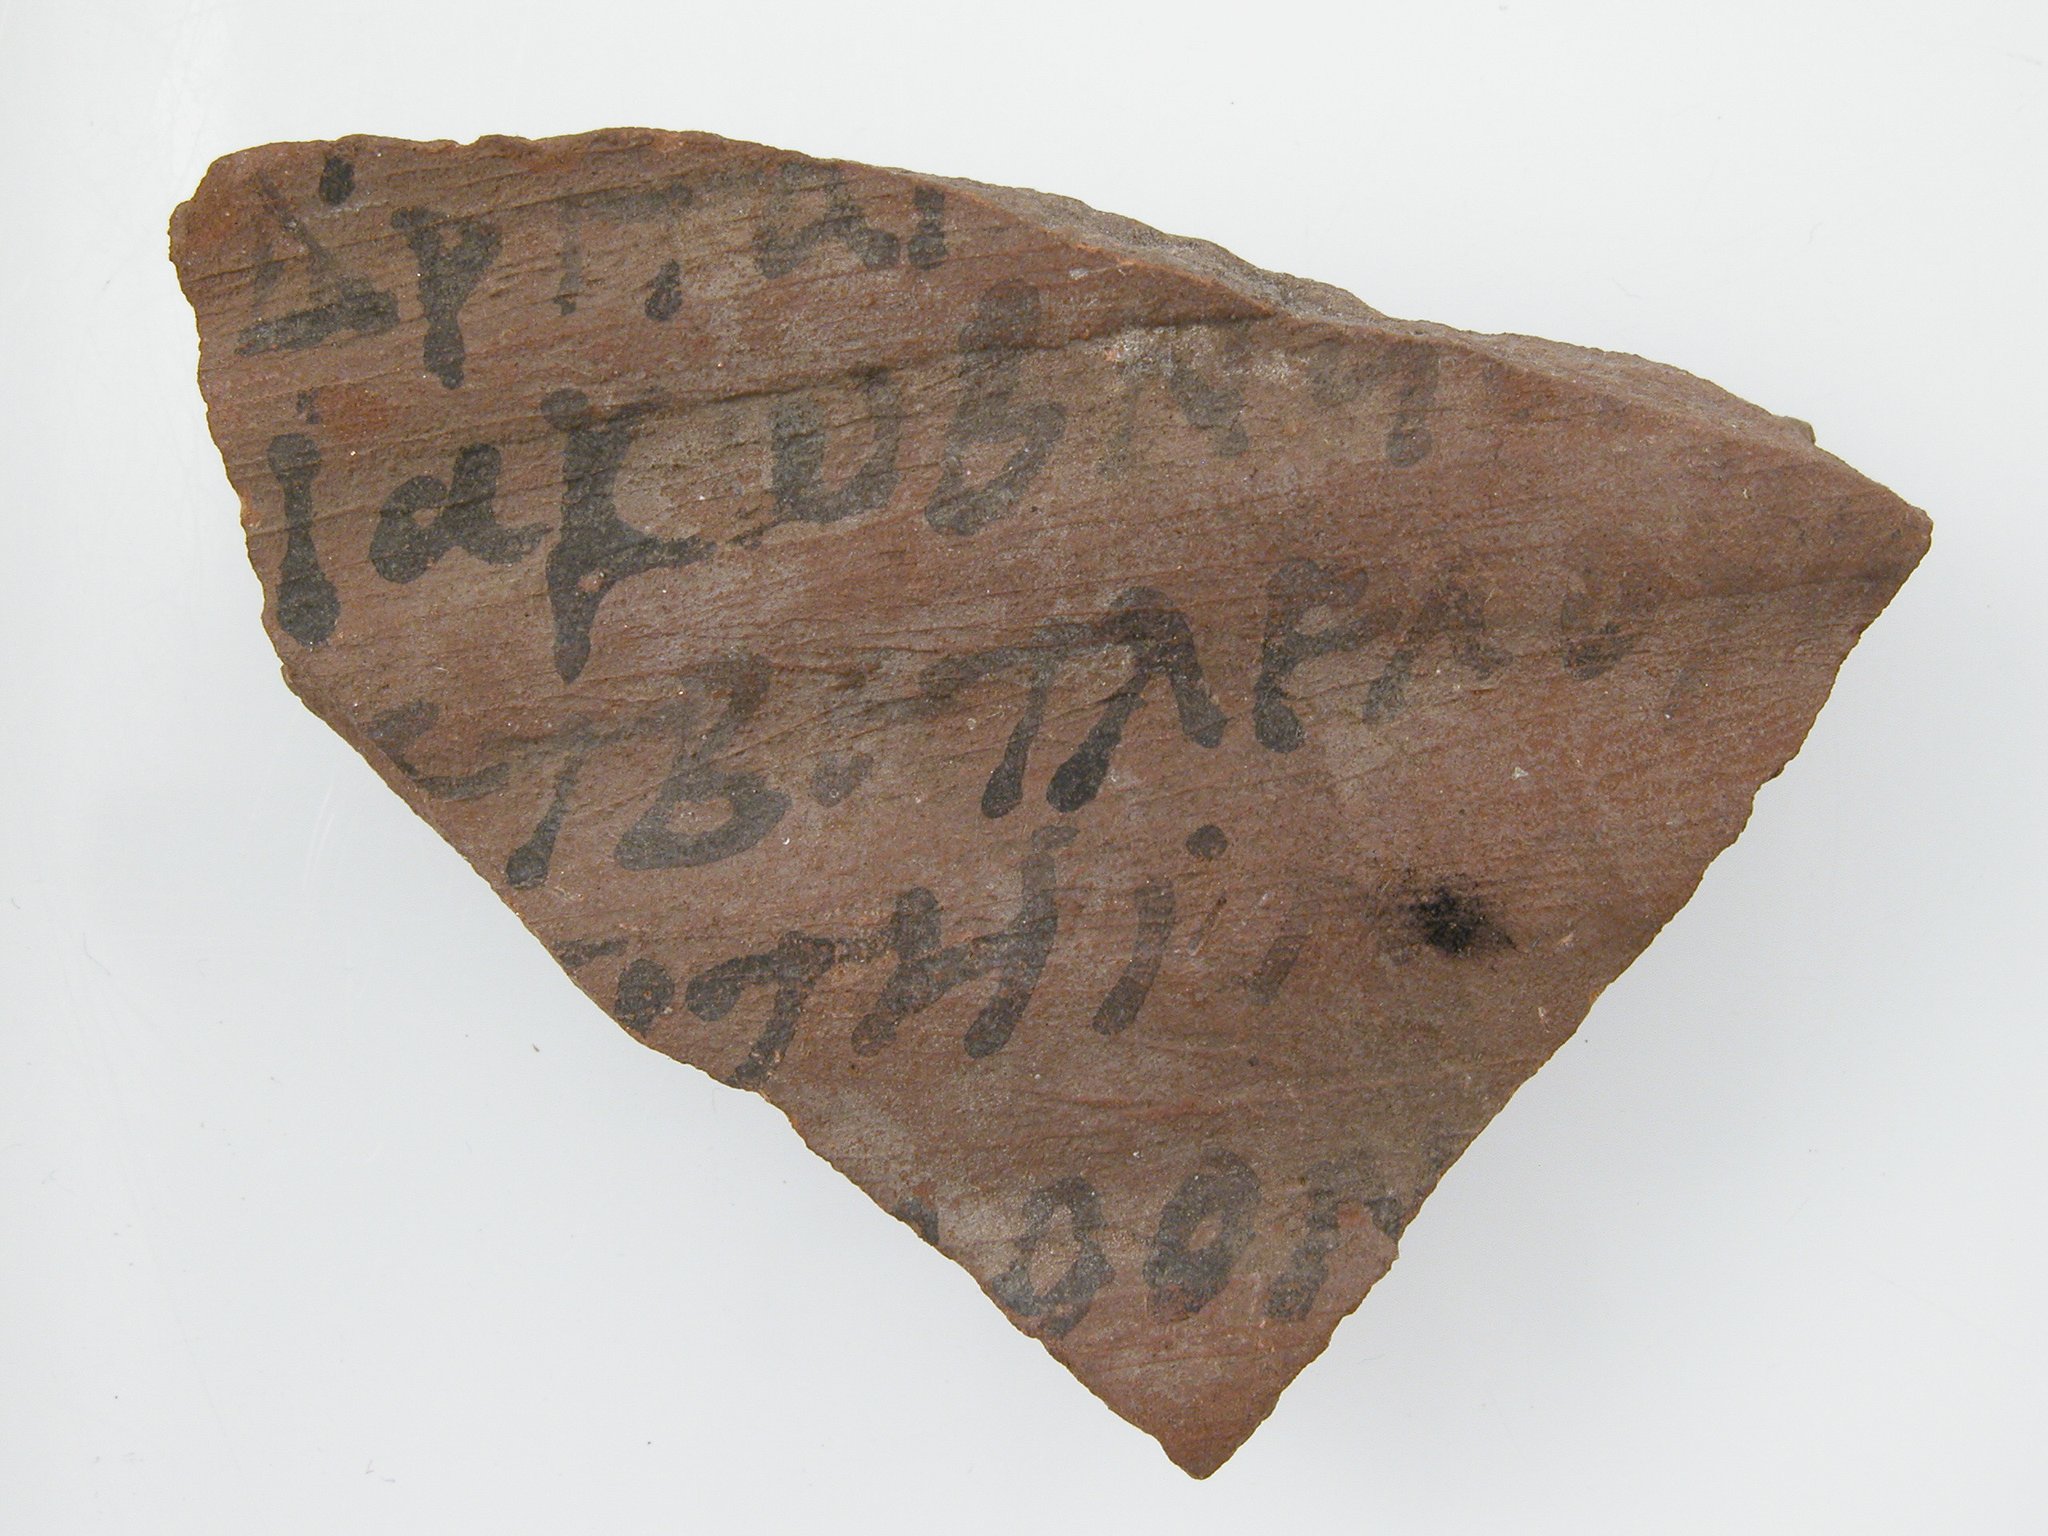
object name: ostrakon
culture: coptic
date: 601-700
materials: ink, pottery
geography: egypt